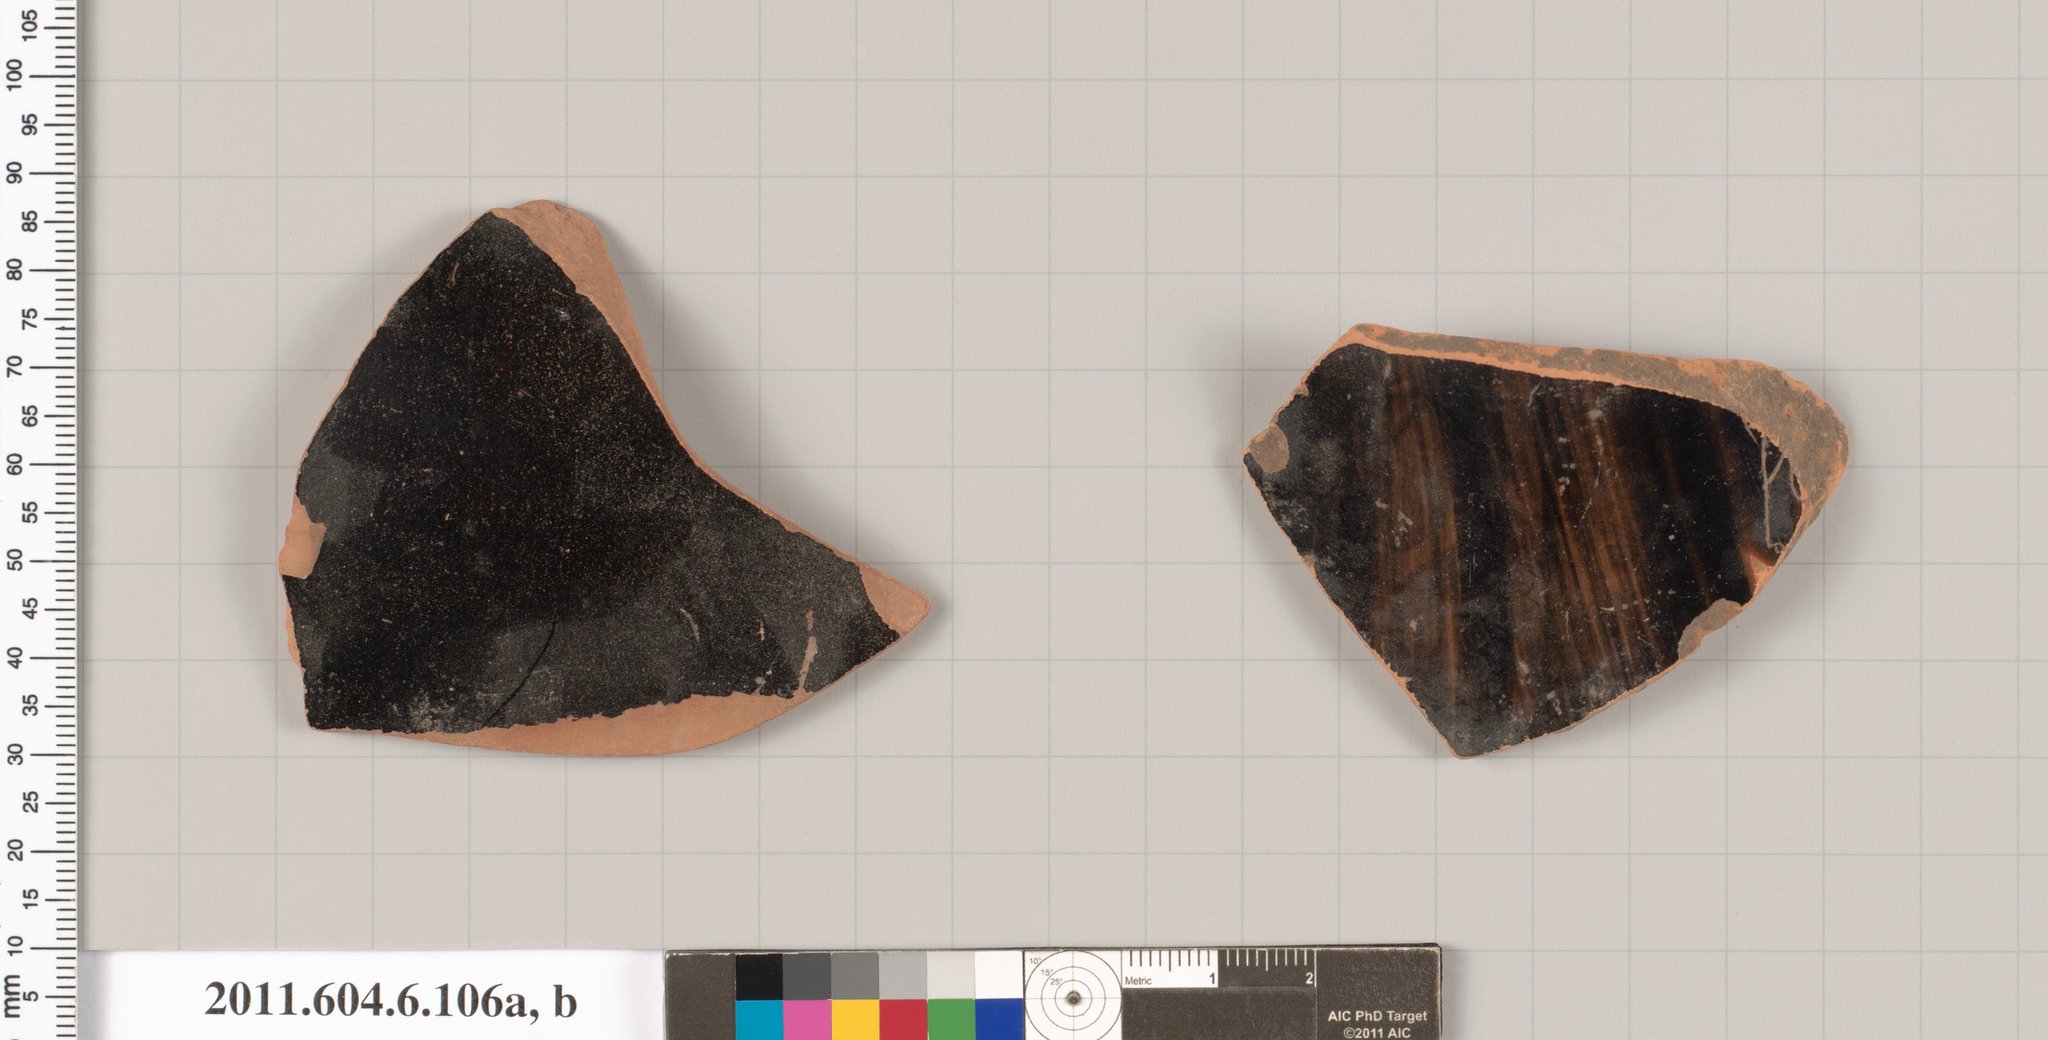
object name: undetermined closed shape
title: Terracotta fragments of closed shapes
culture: greek, attic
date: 600-401 BCE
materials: terracotta